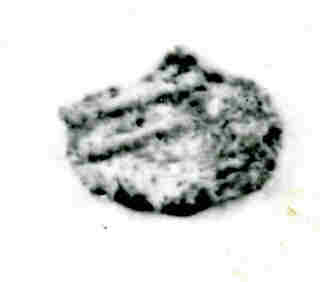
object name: coin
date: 701-900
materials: copper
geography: iran